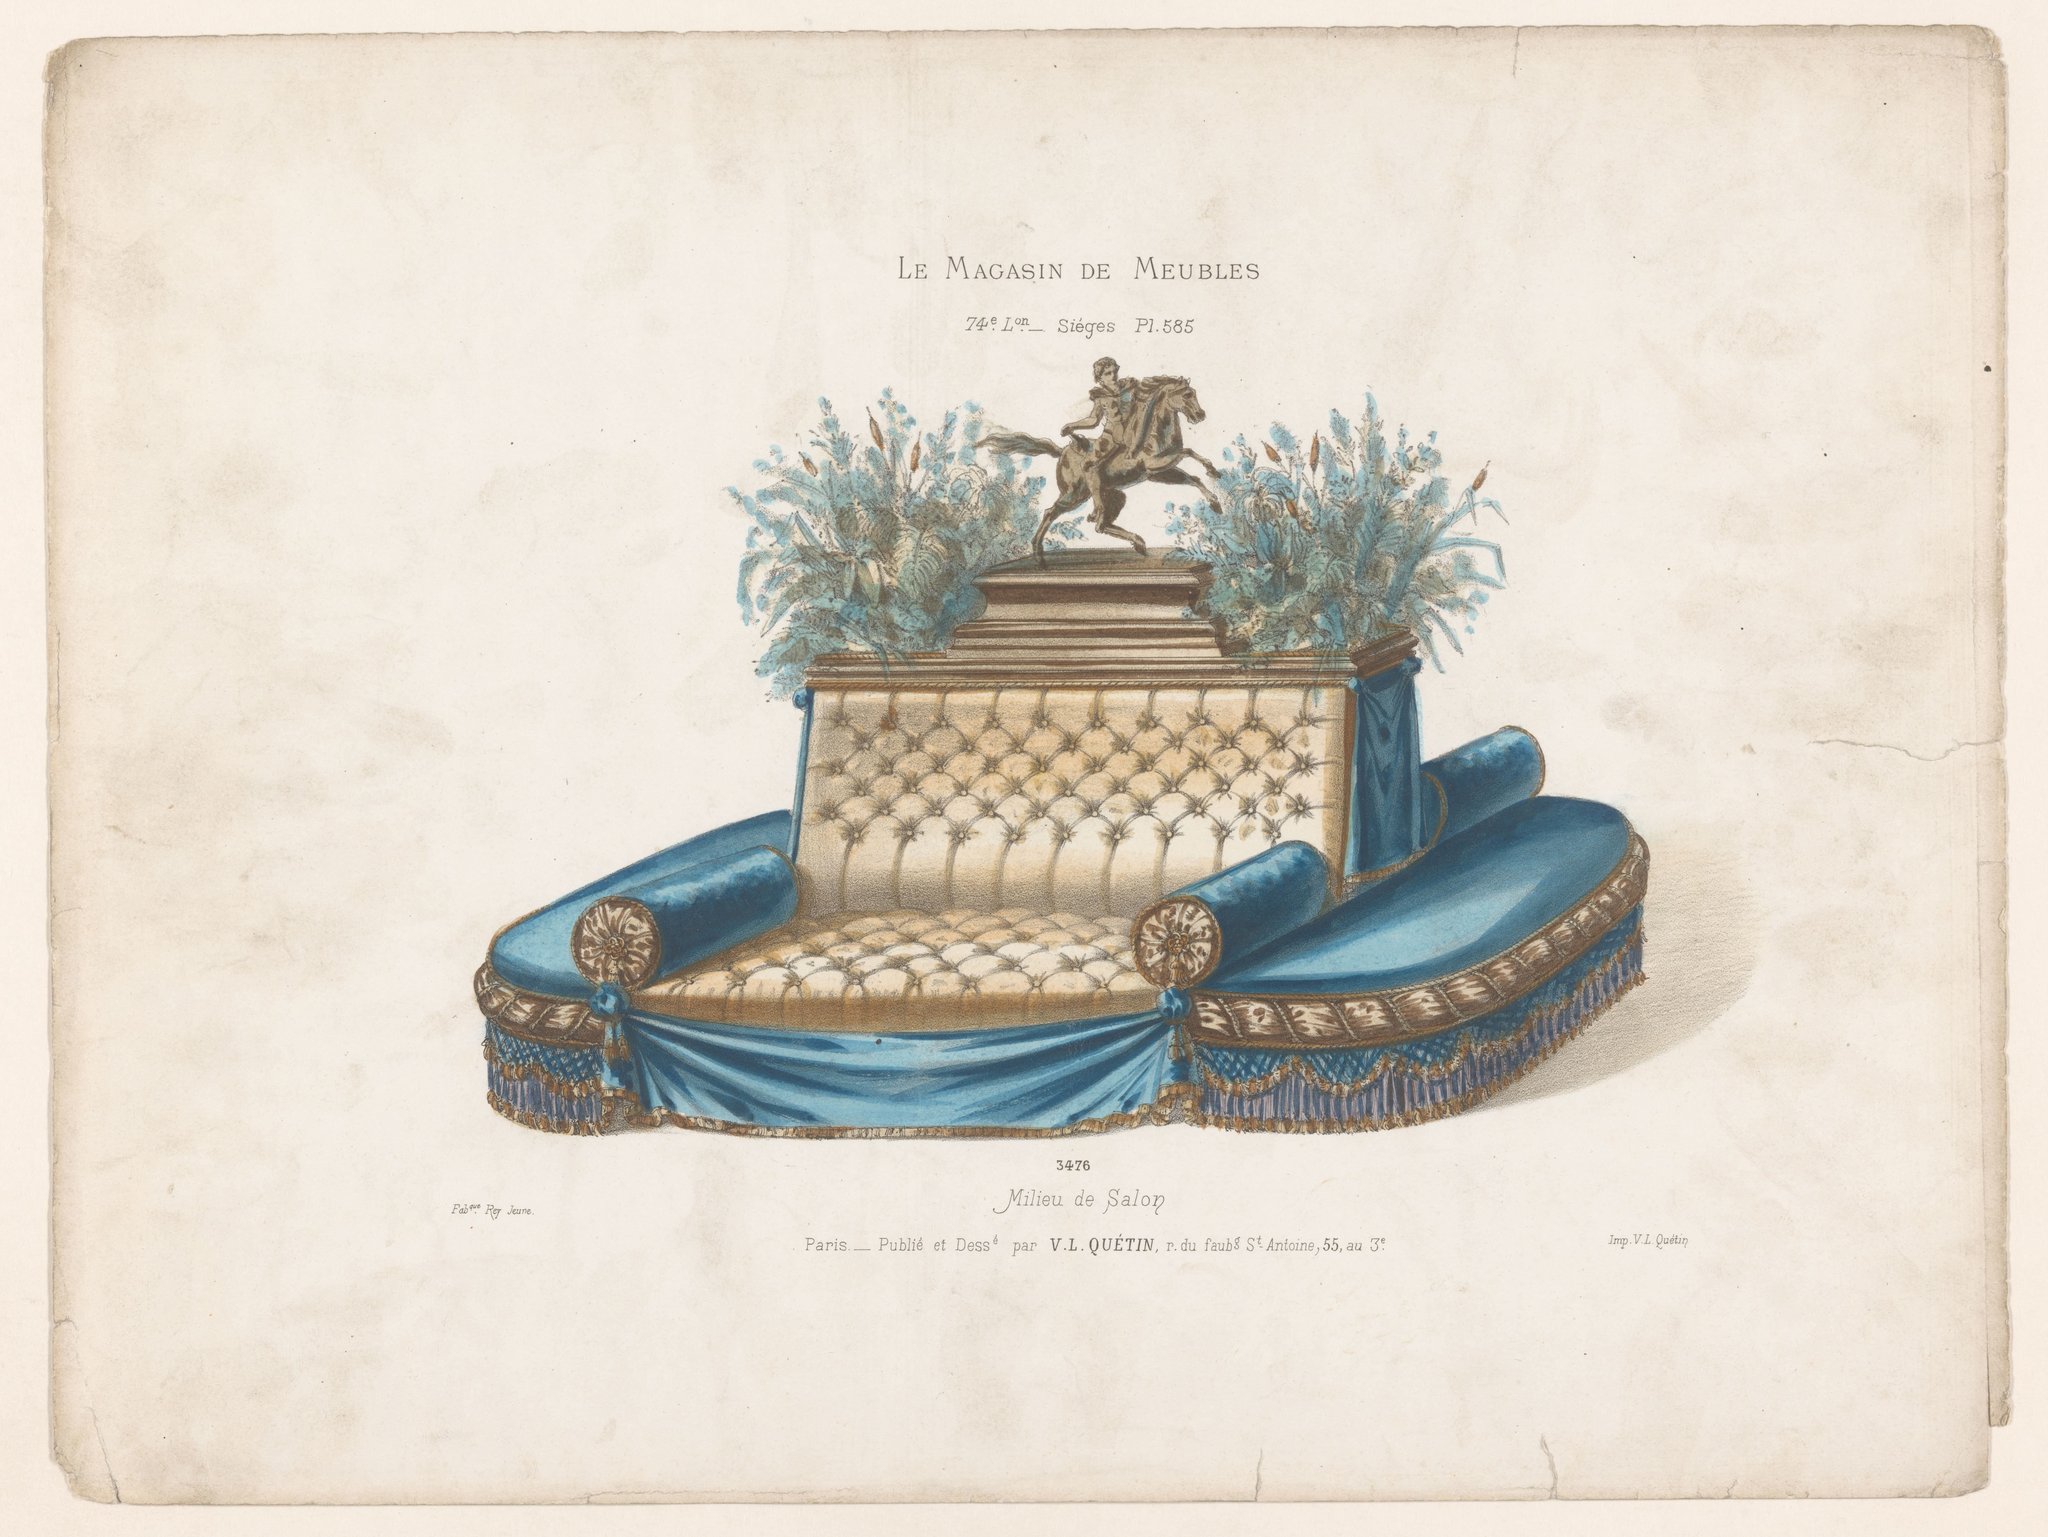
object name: print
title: Le Magasin de Meubles / Sièges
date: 1878-1904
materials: paper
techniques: hand coloring, lithograph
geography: paris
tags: seating furniture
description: Een bank met vier zitplaatsen rondom en in het midden bloemen en een ruitersbeeld. Prent uit 74e Livraison.